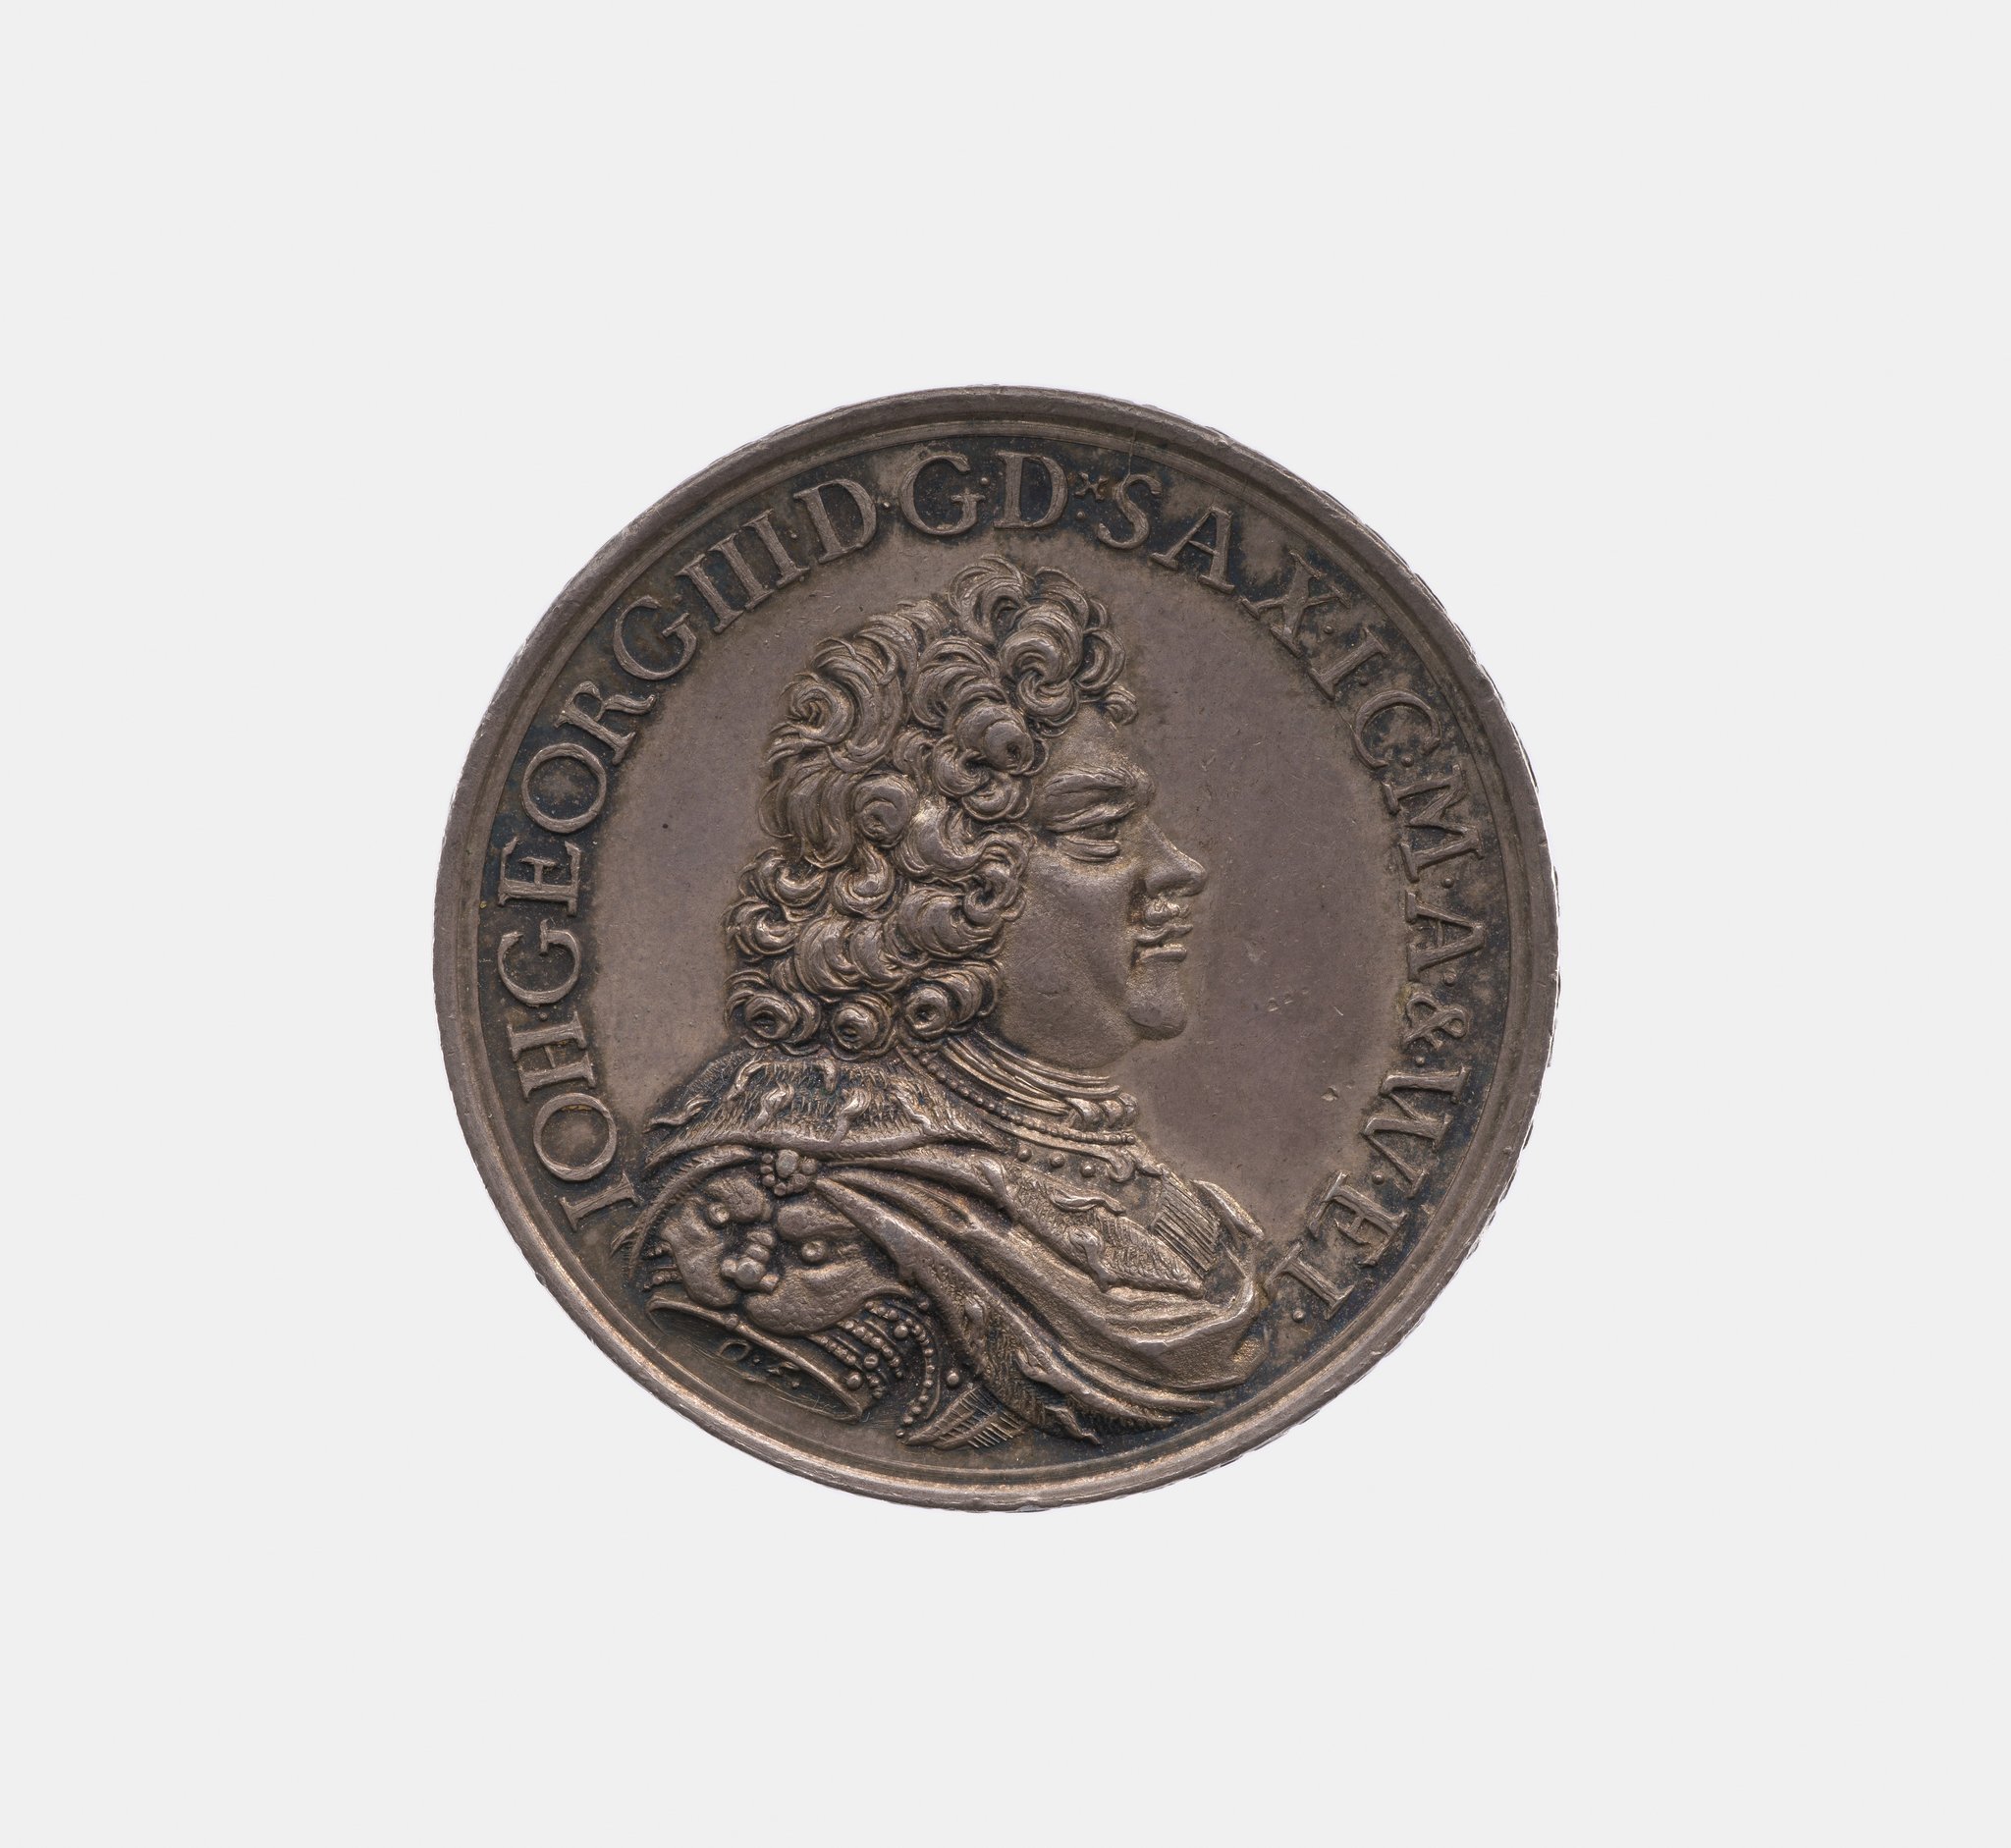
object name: medal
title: John George III 1647-91, Elector of Saxony 1680-91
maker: martin heinrich omeis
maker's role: print maker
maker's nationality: german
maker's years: 1650-1703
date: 1691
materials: silver